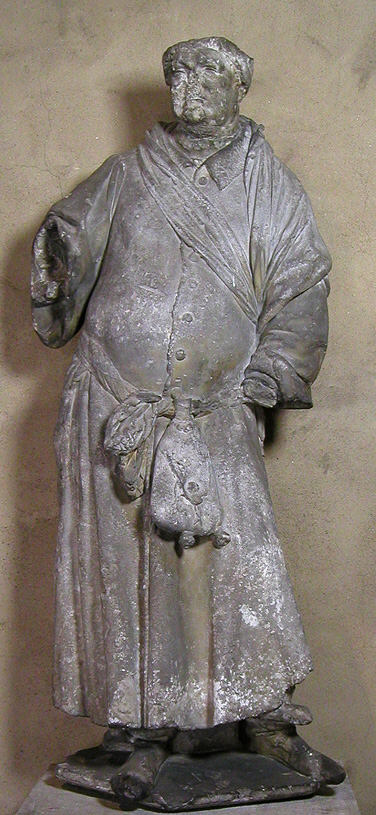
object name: statue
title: St. Cosmas or St. Damian (?)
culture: french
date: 1470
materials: stone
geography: france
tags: men